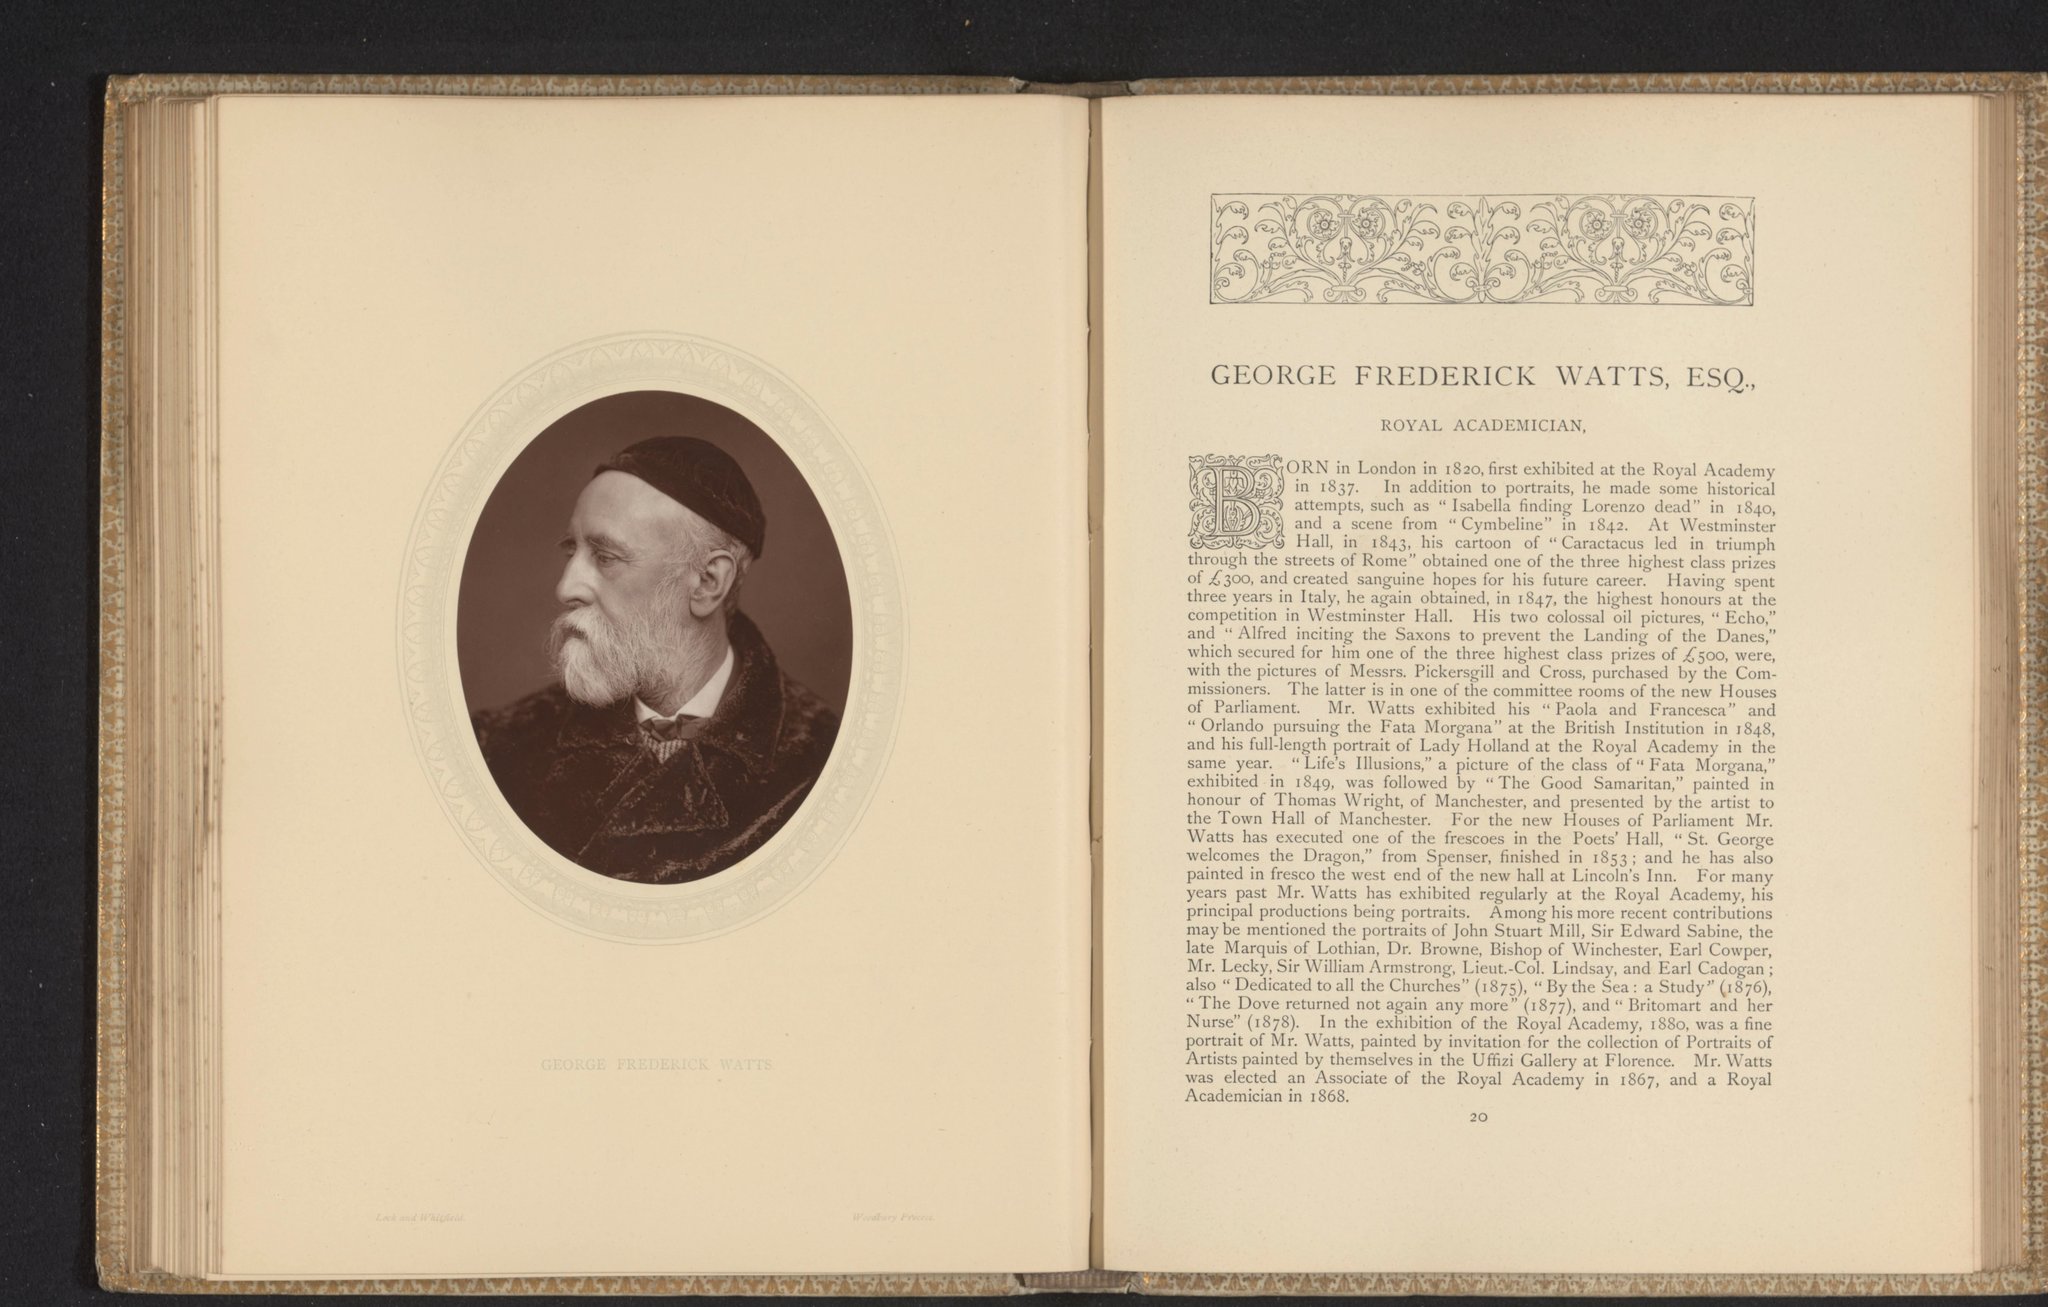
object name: page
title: George Frederick Watts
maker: Anonymous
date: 1877-1882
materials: paper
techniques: woodburytype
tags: painter, george frederick watts, portrait, self-portrait of painter, historical persons (portraits and scenes from the life) (+ (full) bust portrait)